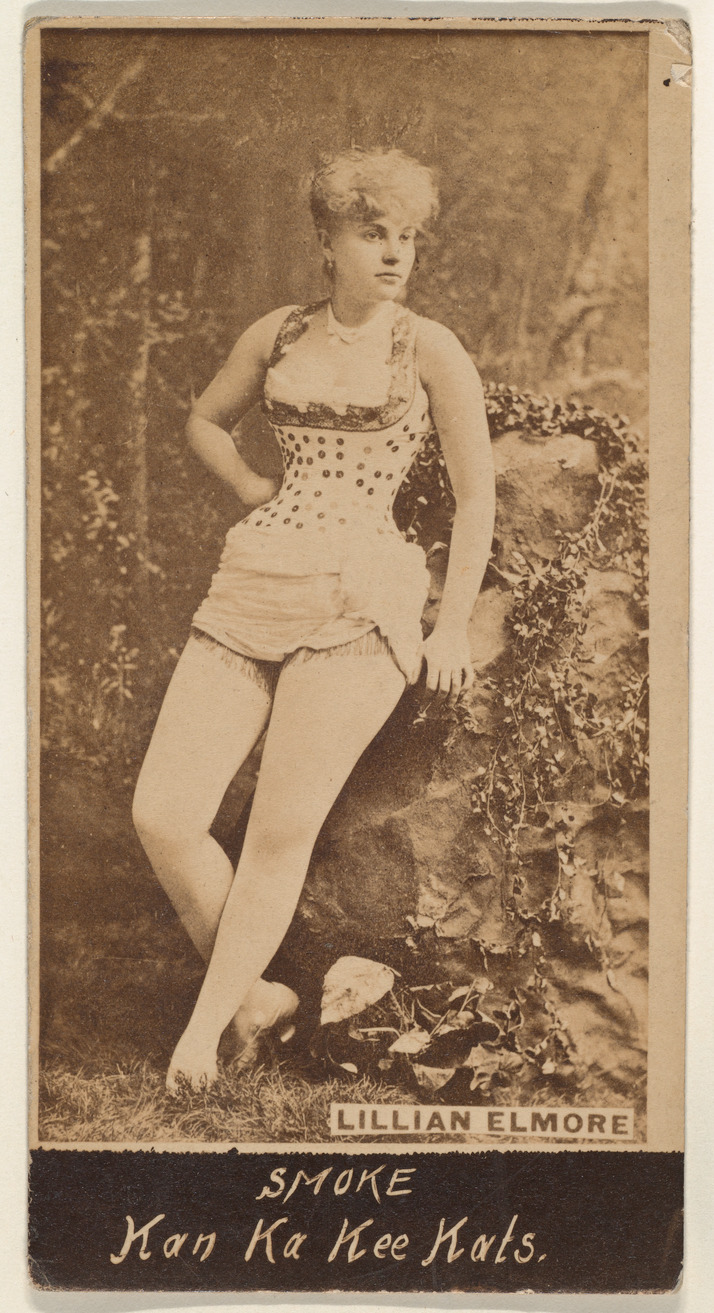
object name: photograph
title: Lillian Elmore, from the Actresses series (N675), promoting Kan Ka Kee Kats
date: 1888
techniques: albumen silver print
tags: portraits,women,actresses